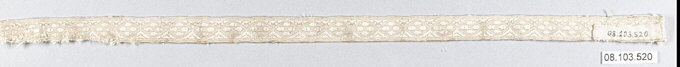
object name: galloon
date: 1701-1900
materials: silk